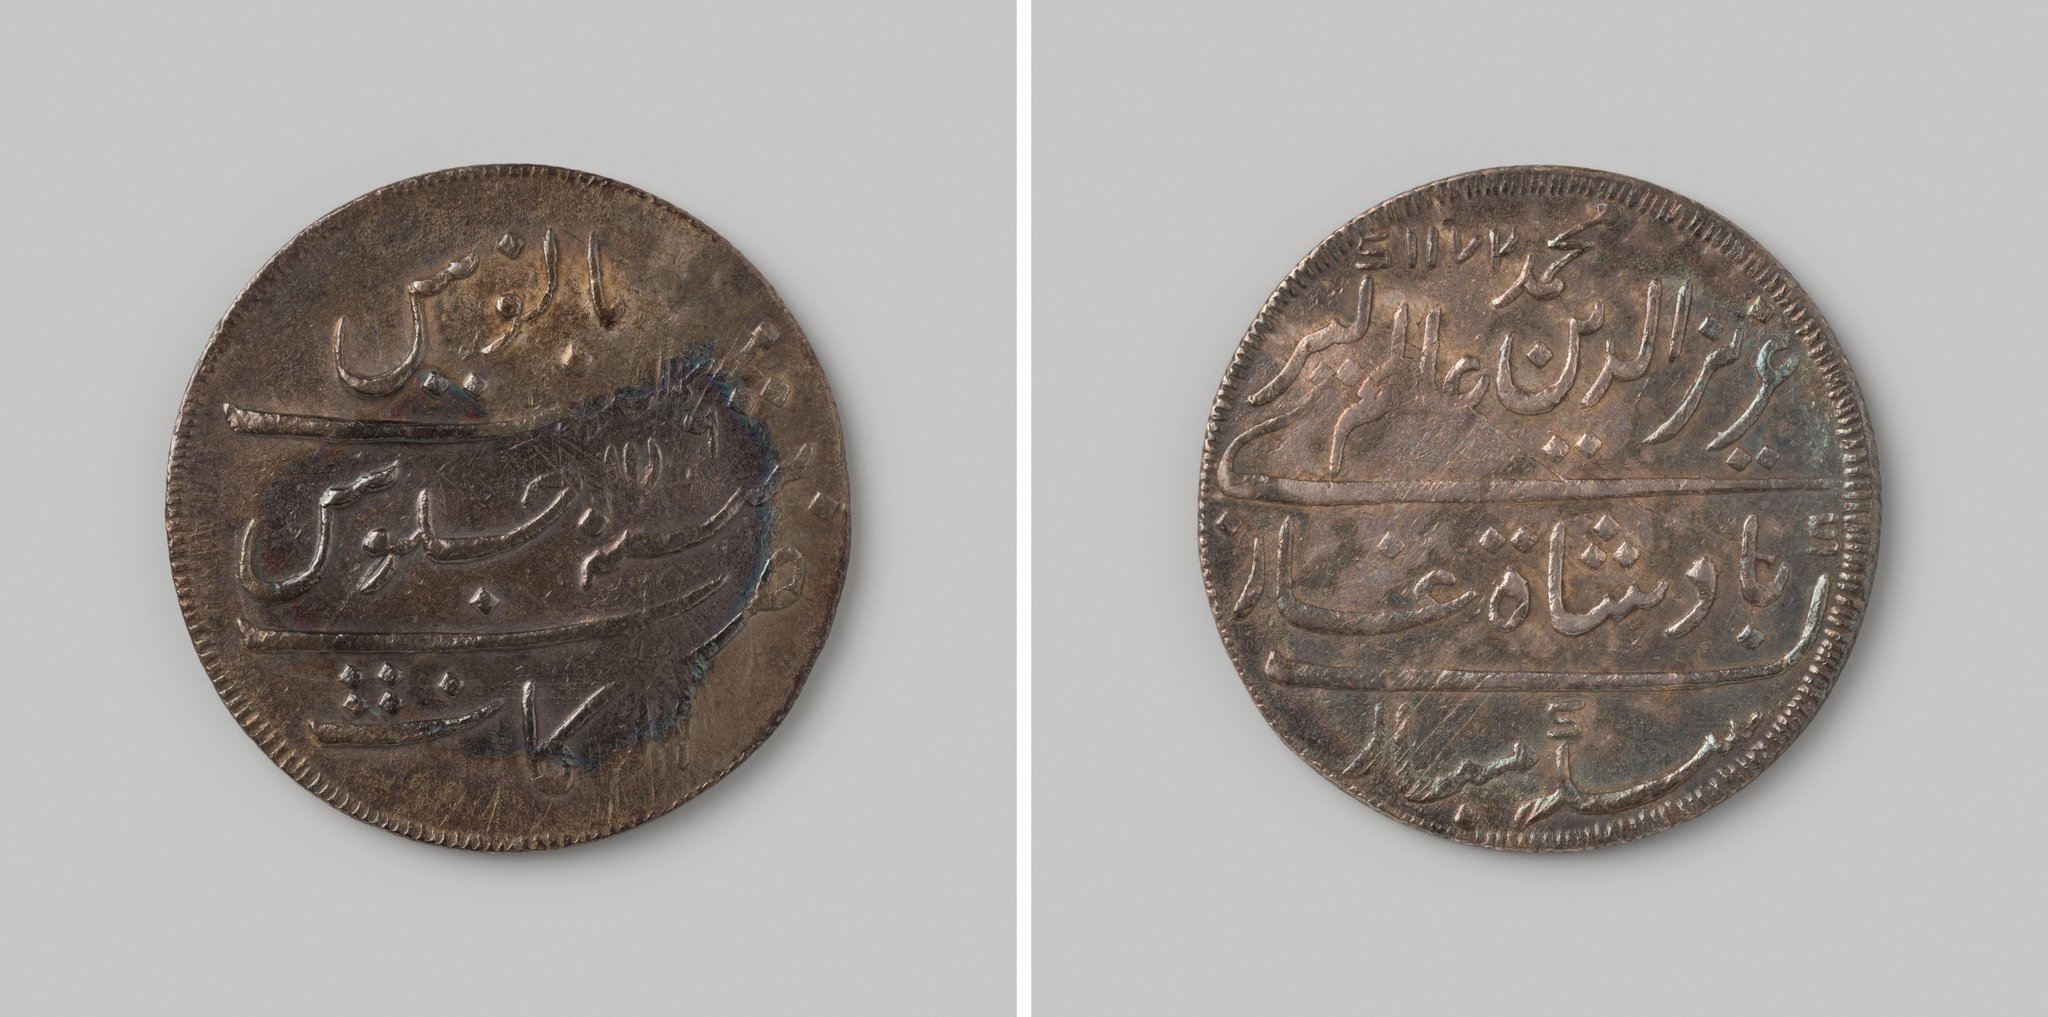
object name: coin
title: India, Engelse Oostindische Compagnie (EIC) , dubbele arcot-roepie voor Madras, India, op naam van shah Alamgir II, (1807)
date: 1807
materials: silver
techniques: striking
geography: chennai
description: Zilveren munt. Voorzijde: opschrift in drie regels in Arabische lettertekens, waarin verwijzing naar shah Alamgir II. Links boven "bevroren" jaartal: 1172. Keerzijde: opschrift in drie regels in Arabische lettertekens. Rechts boven tweede regel lotusbloem. Kabelrand.